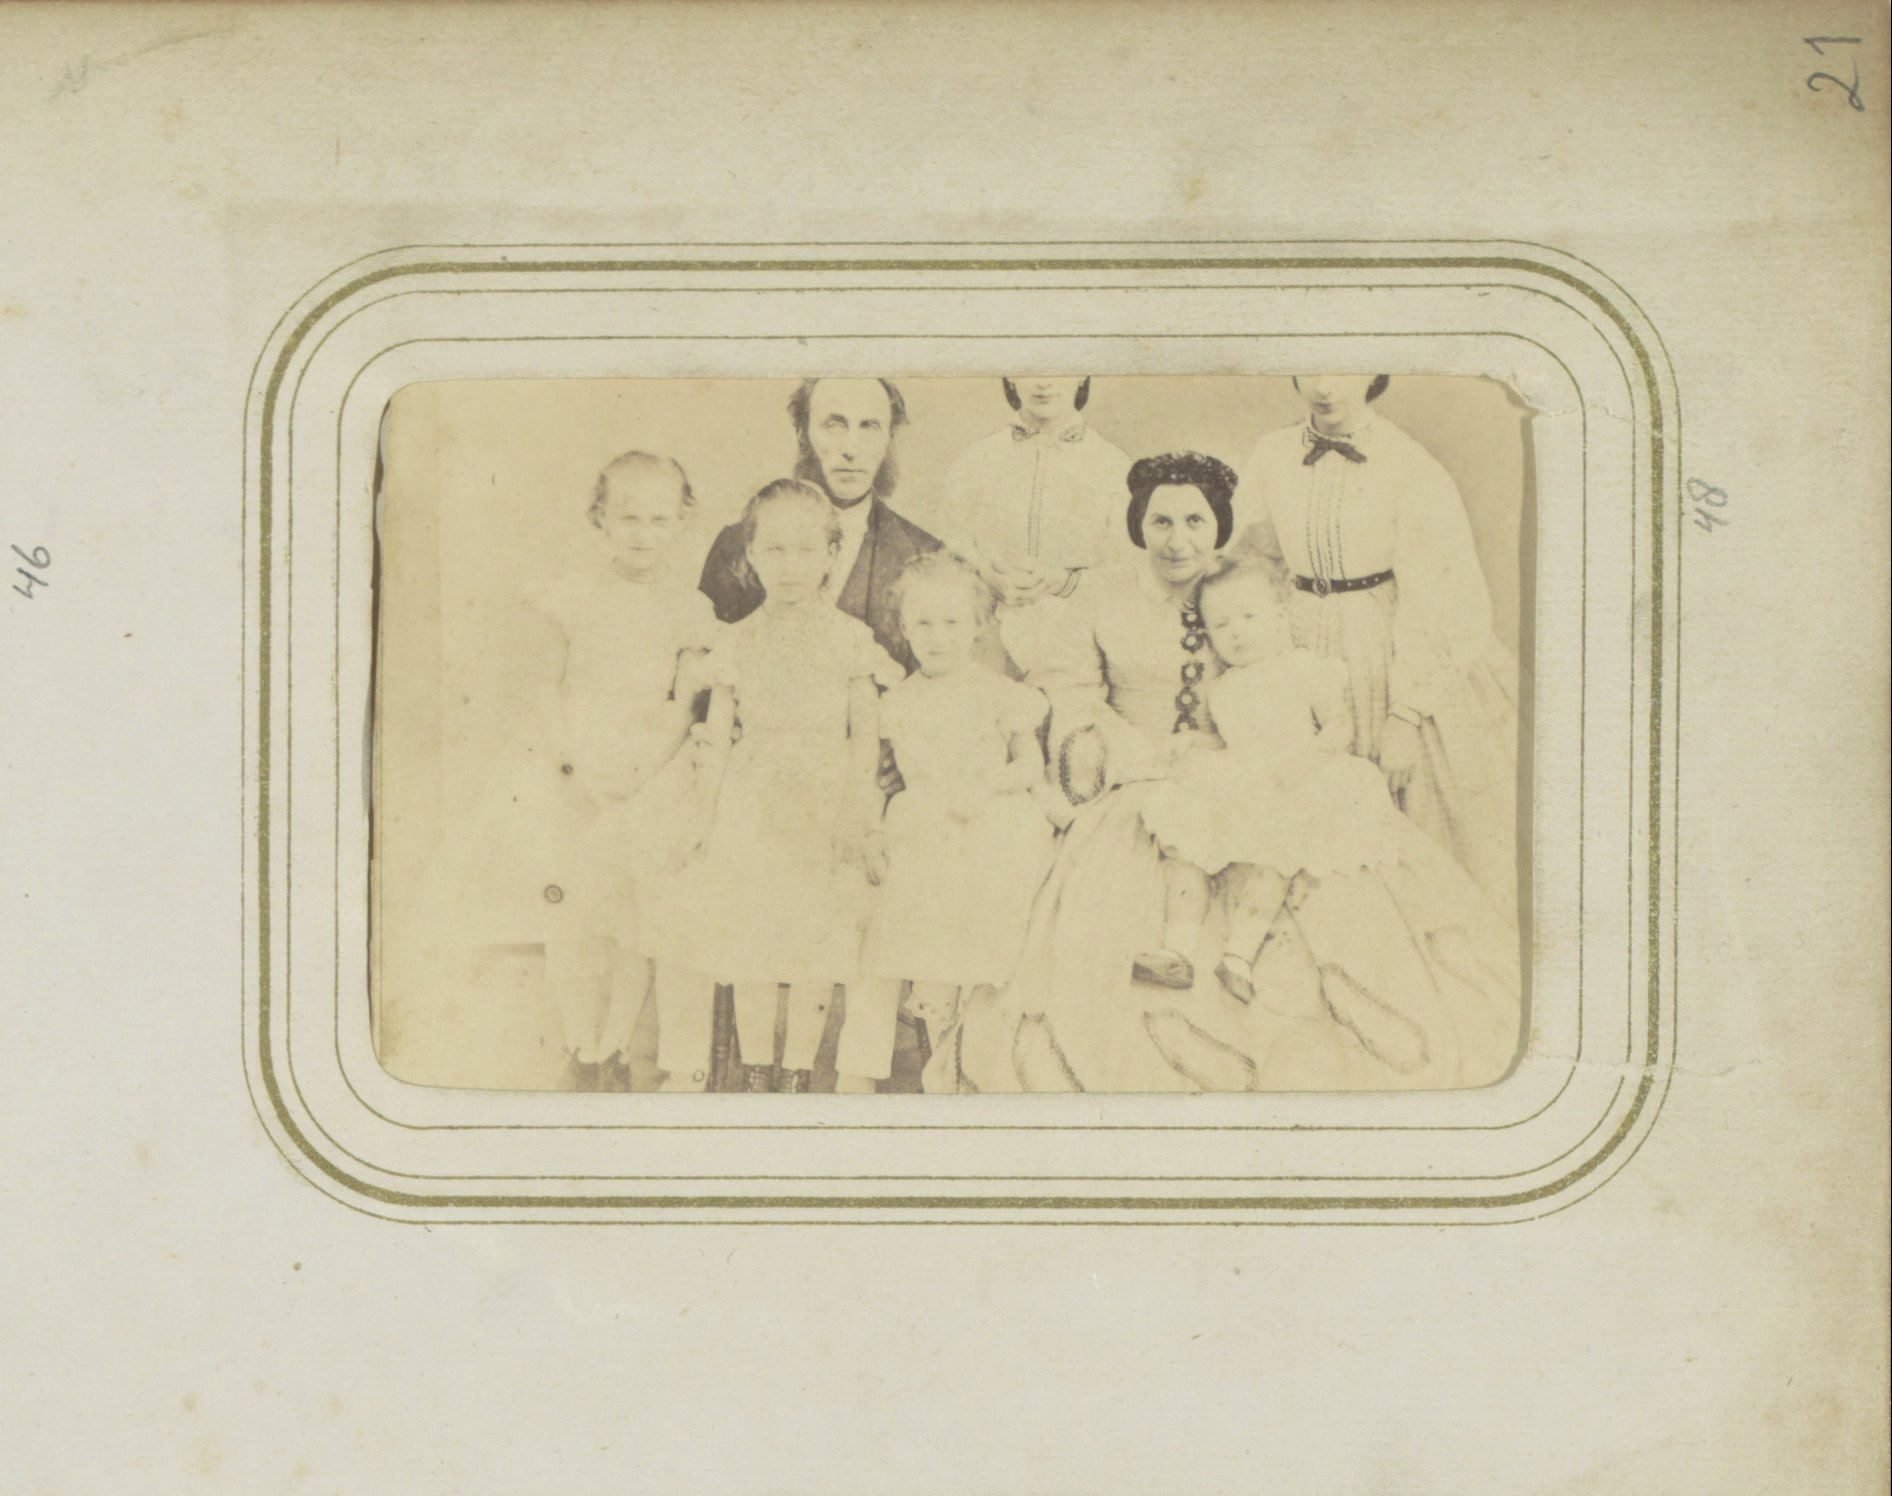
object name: photograph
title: Portret van een gezin met zes kinderen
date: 1880-1900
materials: cardboard, photographic support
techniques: albumen print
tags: adolescent, young woman, maiden, sideburns, belt, girdle, waistband, family group, especially parents with their child(ren), child, historical persons, styles of hairdress - aa - ~ women, family, relationship, descent, shoes, sandals, dress, gown, tot, toddler ~ the ages of man, netherlands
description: Onderdeel van Familiealbum van H.W.F. Ligtenberg en L.M. Swart met 149 foto's en cartes-de-visite.